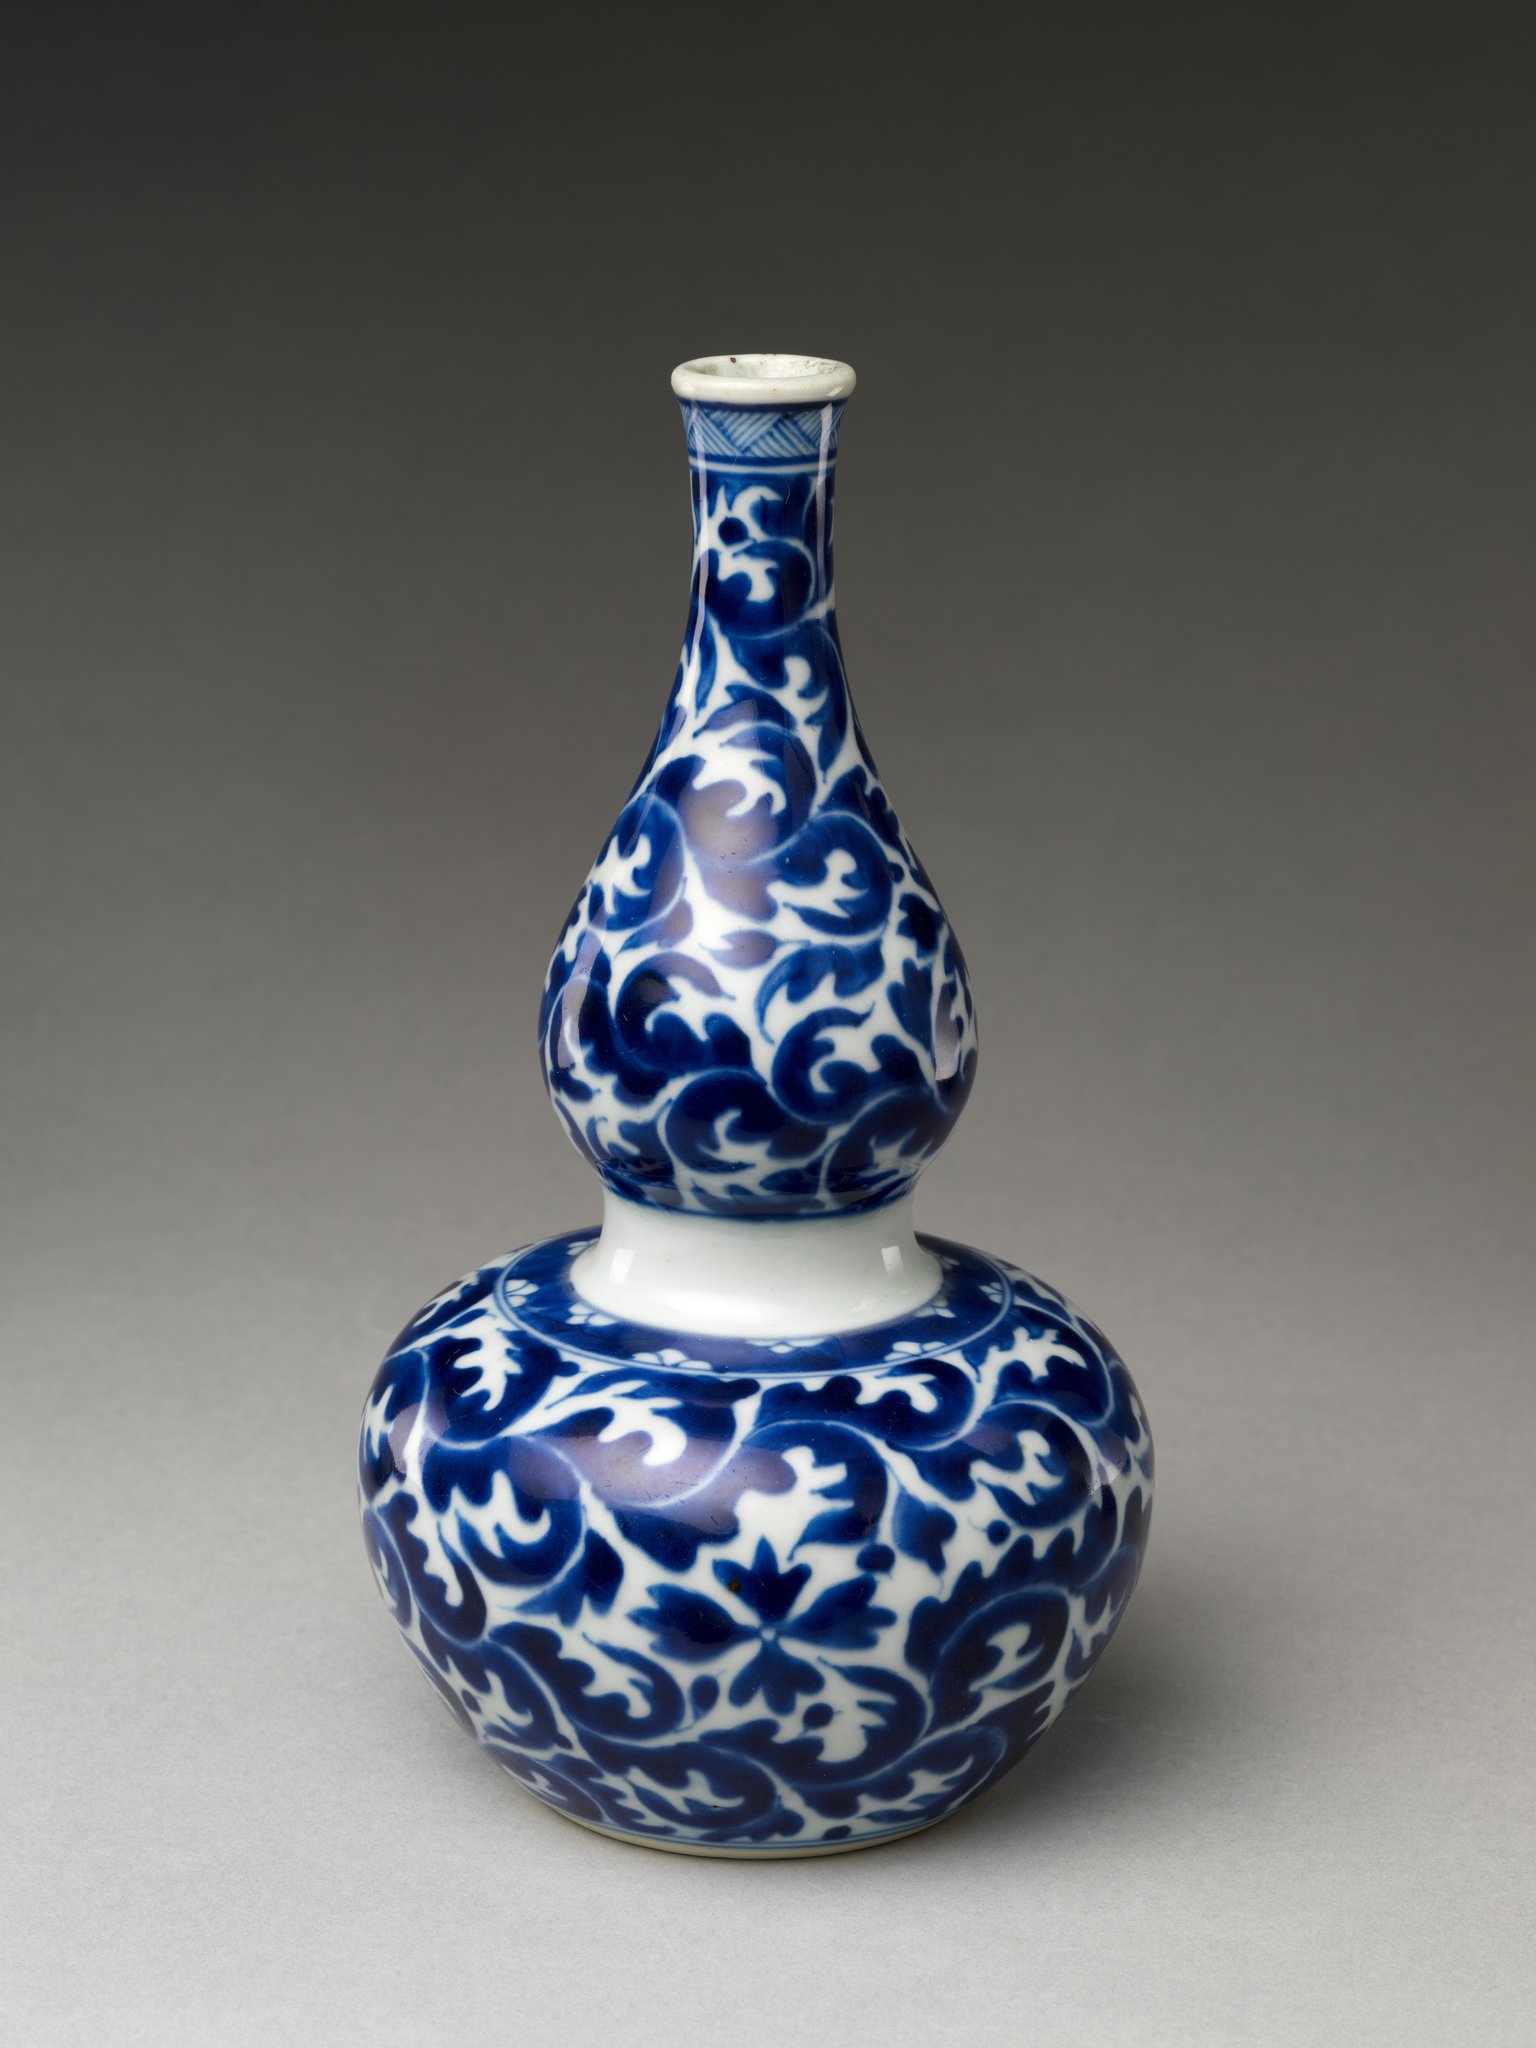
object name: bottle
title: Double gourd bottle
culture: chinese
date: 1701-1800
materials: porcelain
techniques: underglaze